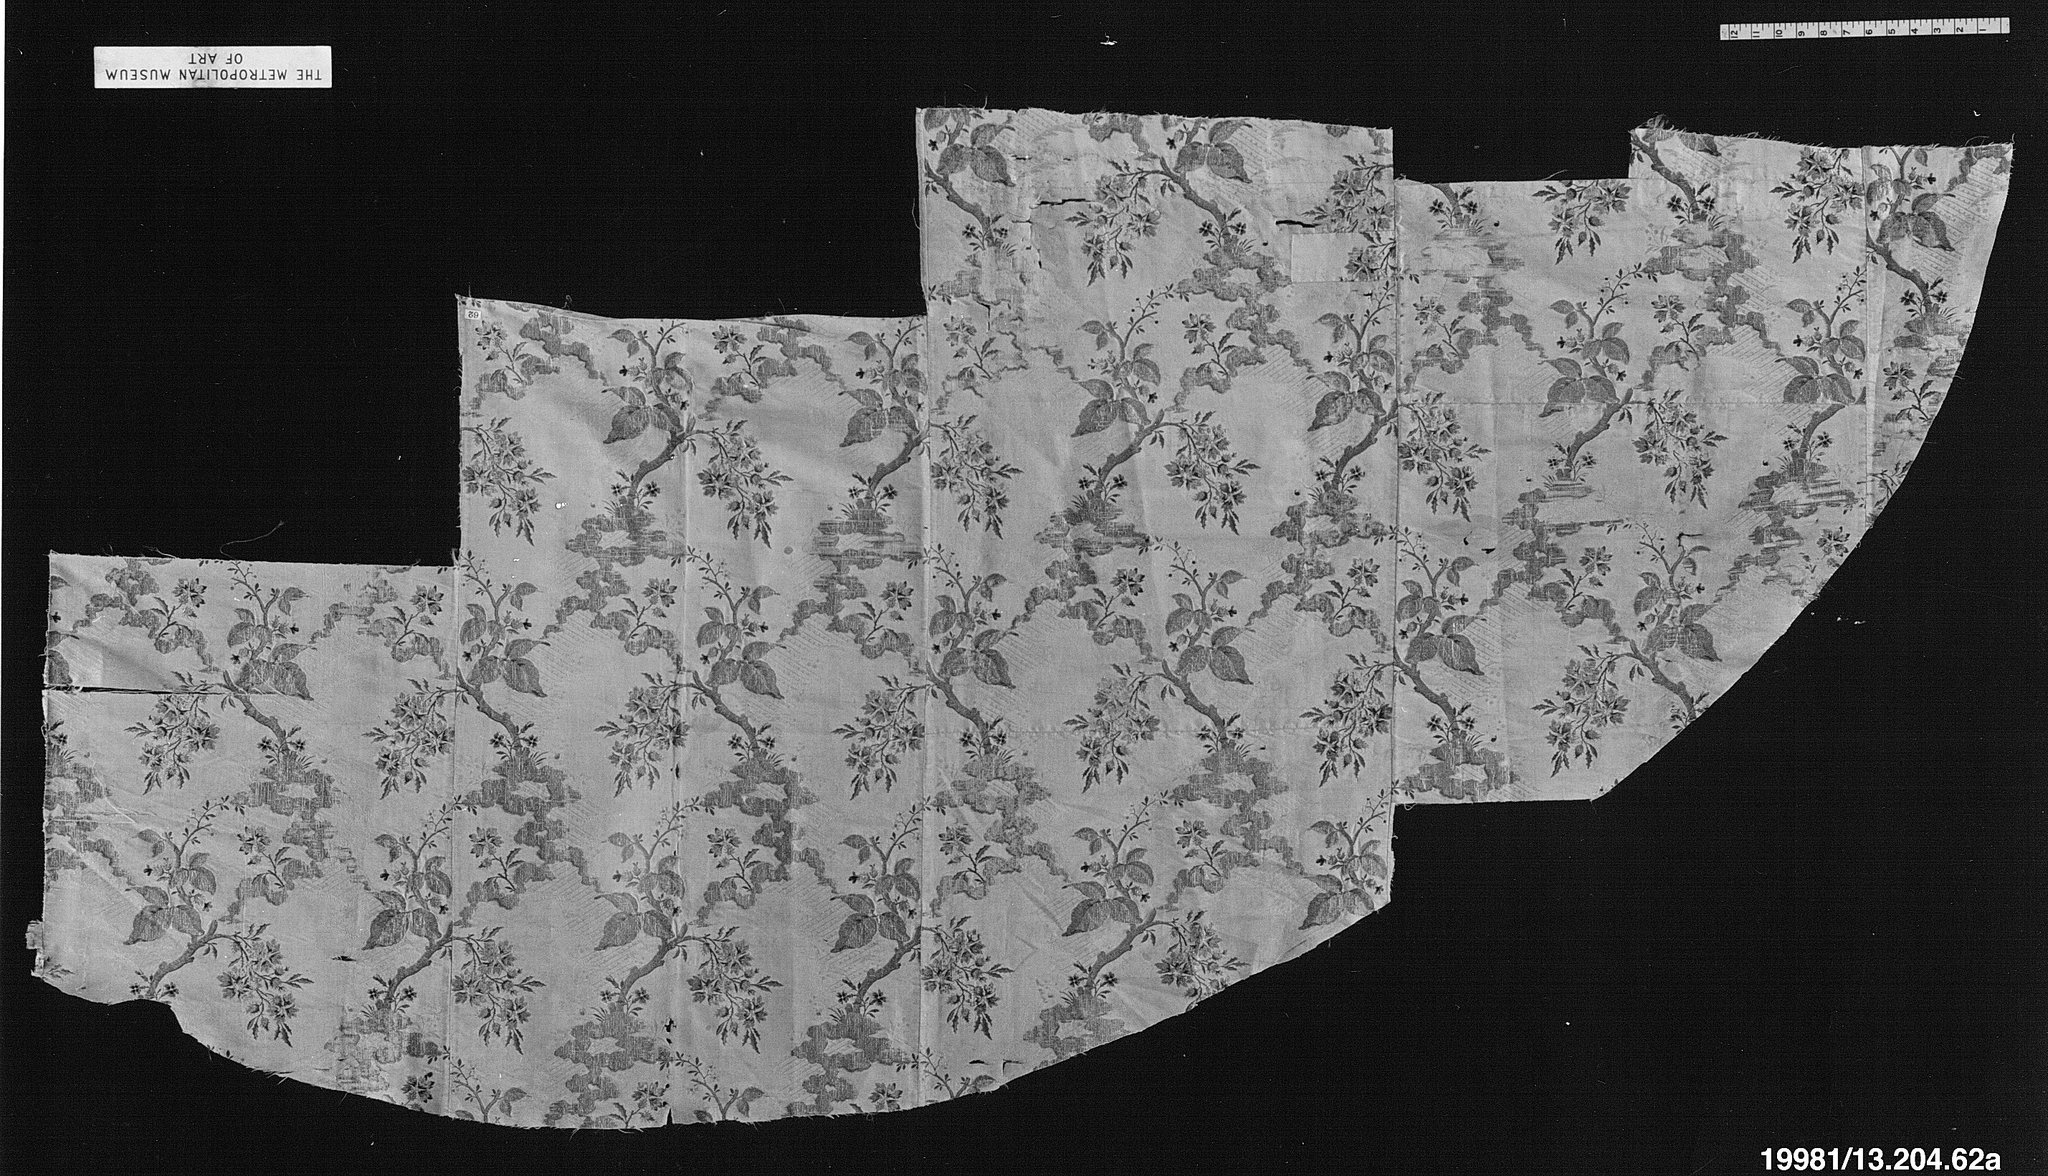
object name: piece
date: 1750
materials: metal thread, silk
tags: flowers,leaves